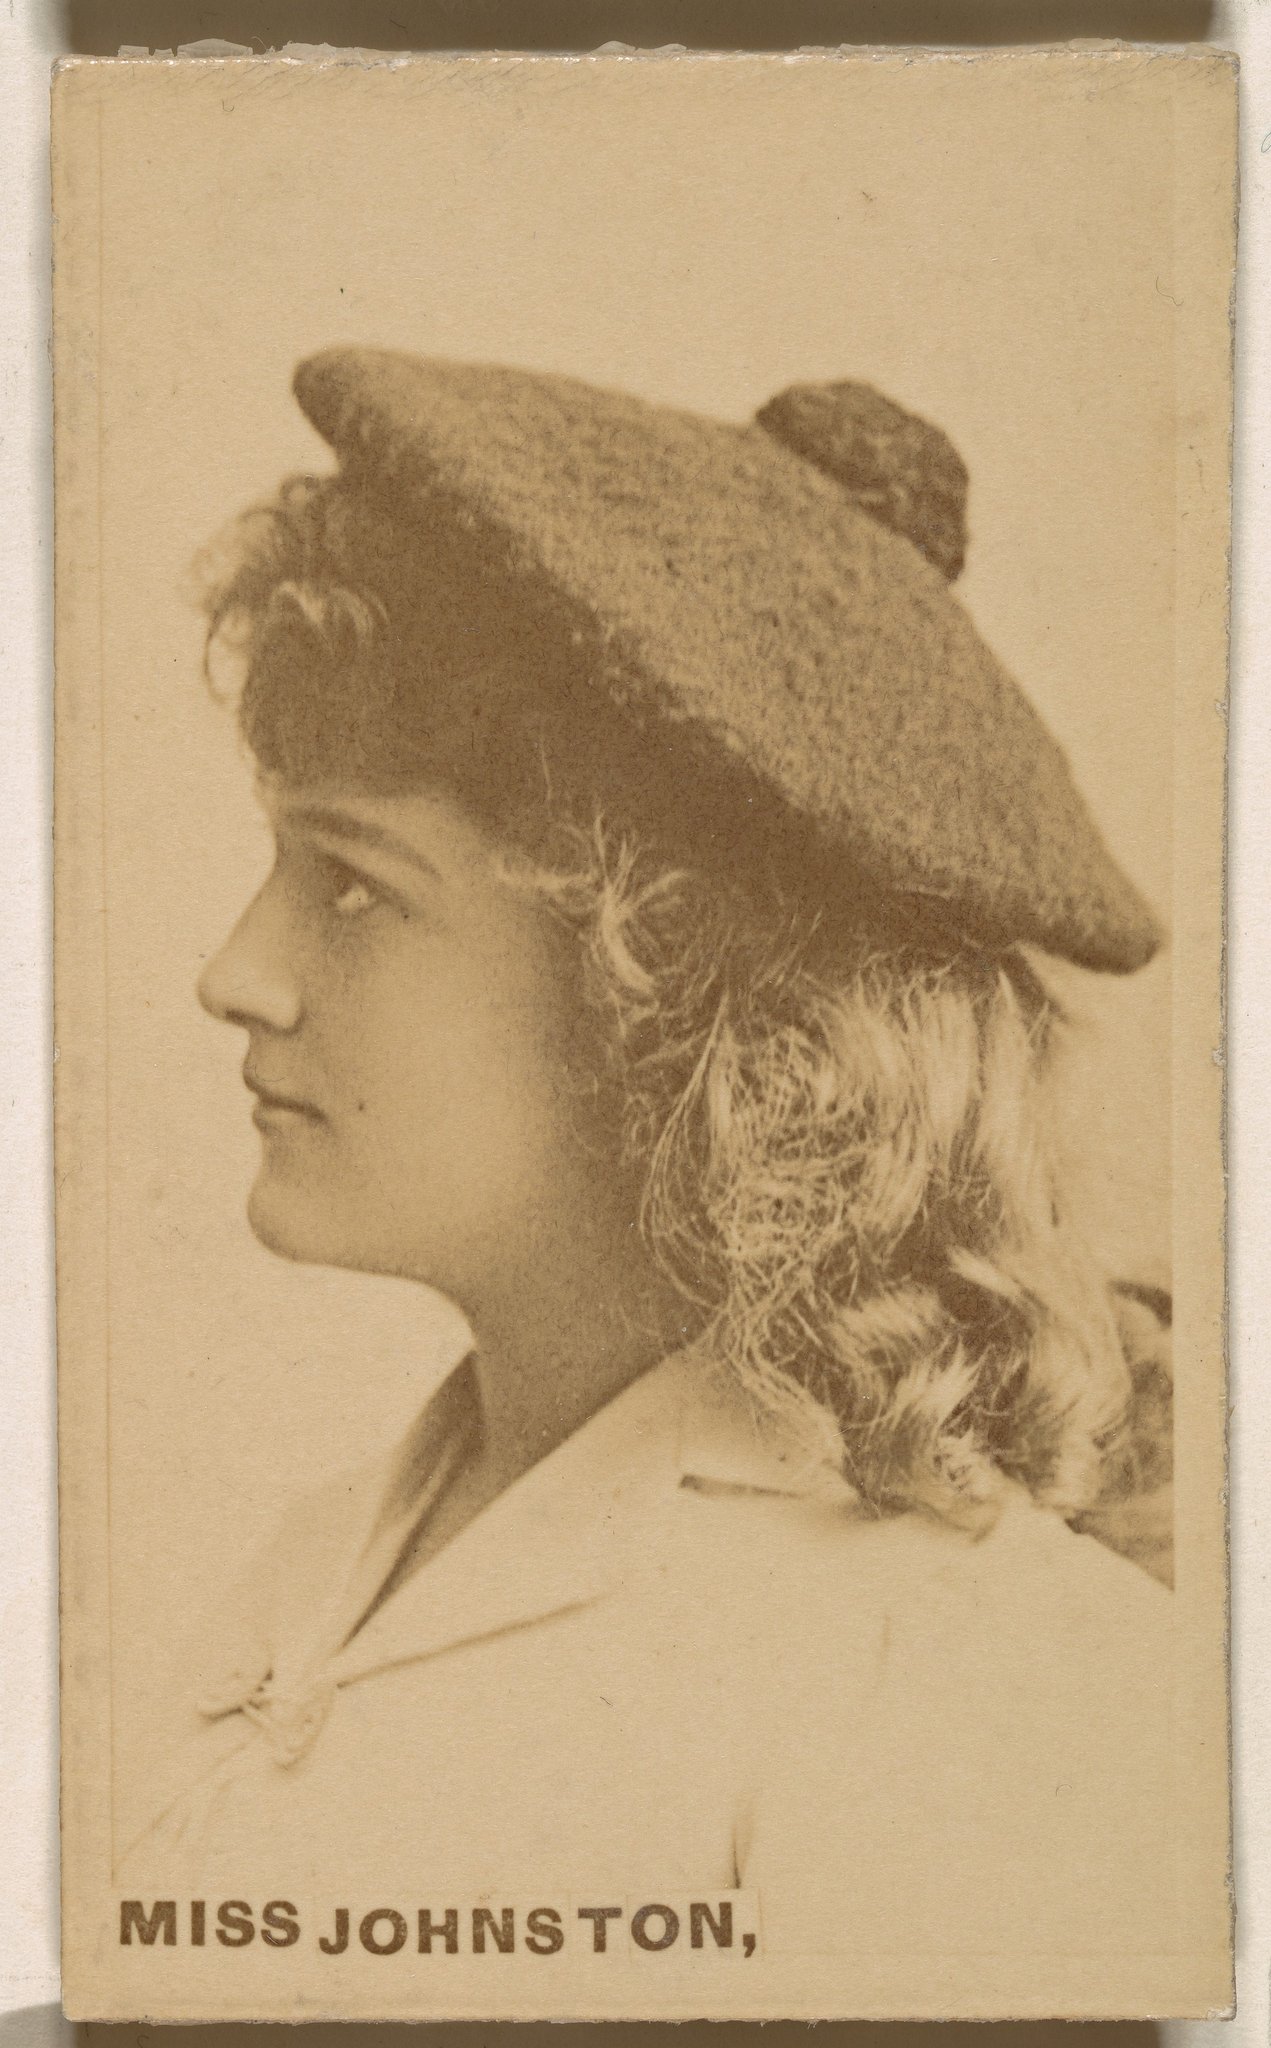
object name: photograph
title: Miss Johnston, from the Actresses series (N246), Type 1, issued by Kinney Brothers to promote Sporting Extra Cigarettes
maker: kinney brothers tobacco company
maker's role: publisher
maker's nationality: american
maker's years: 1869-2011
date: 1890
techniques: albumen silver print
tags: women,actresses